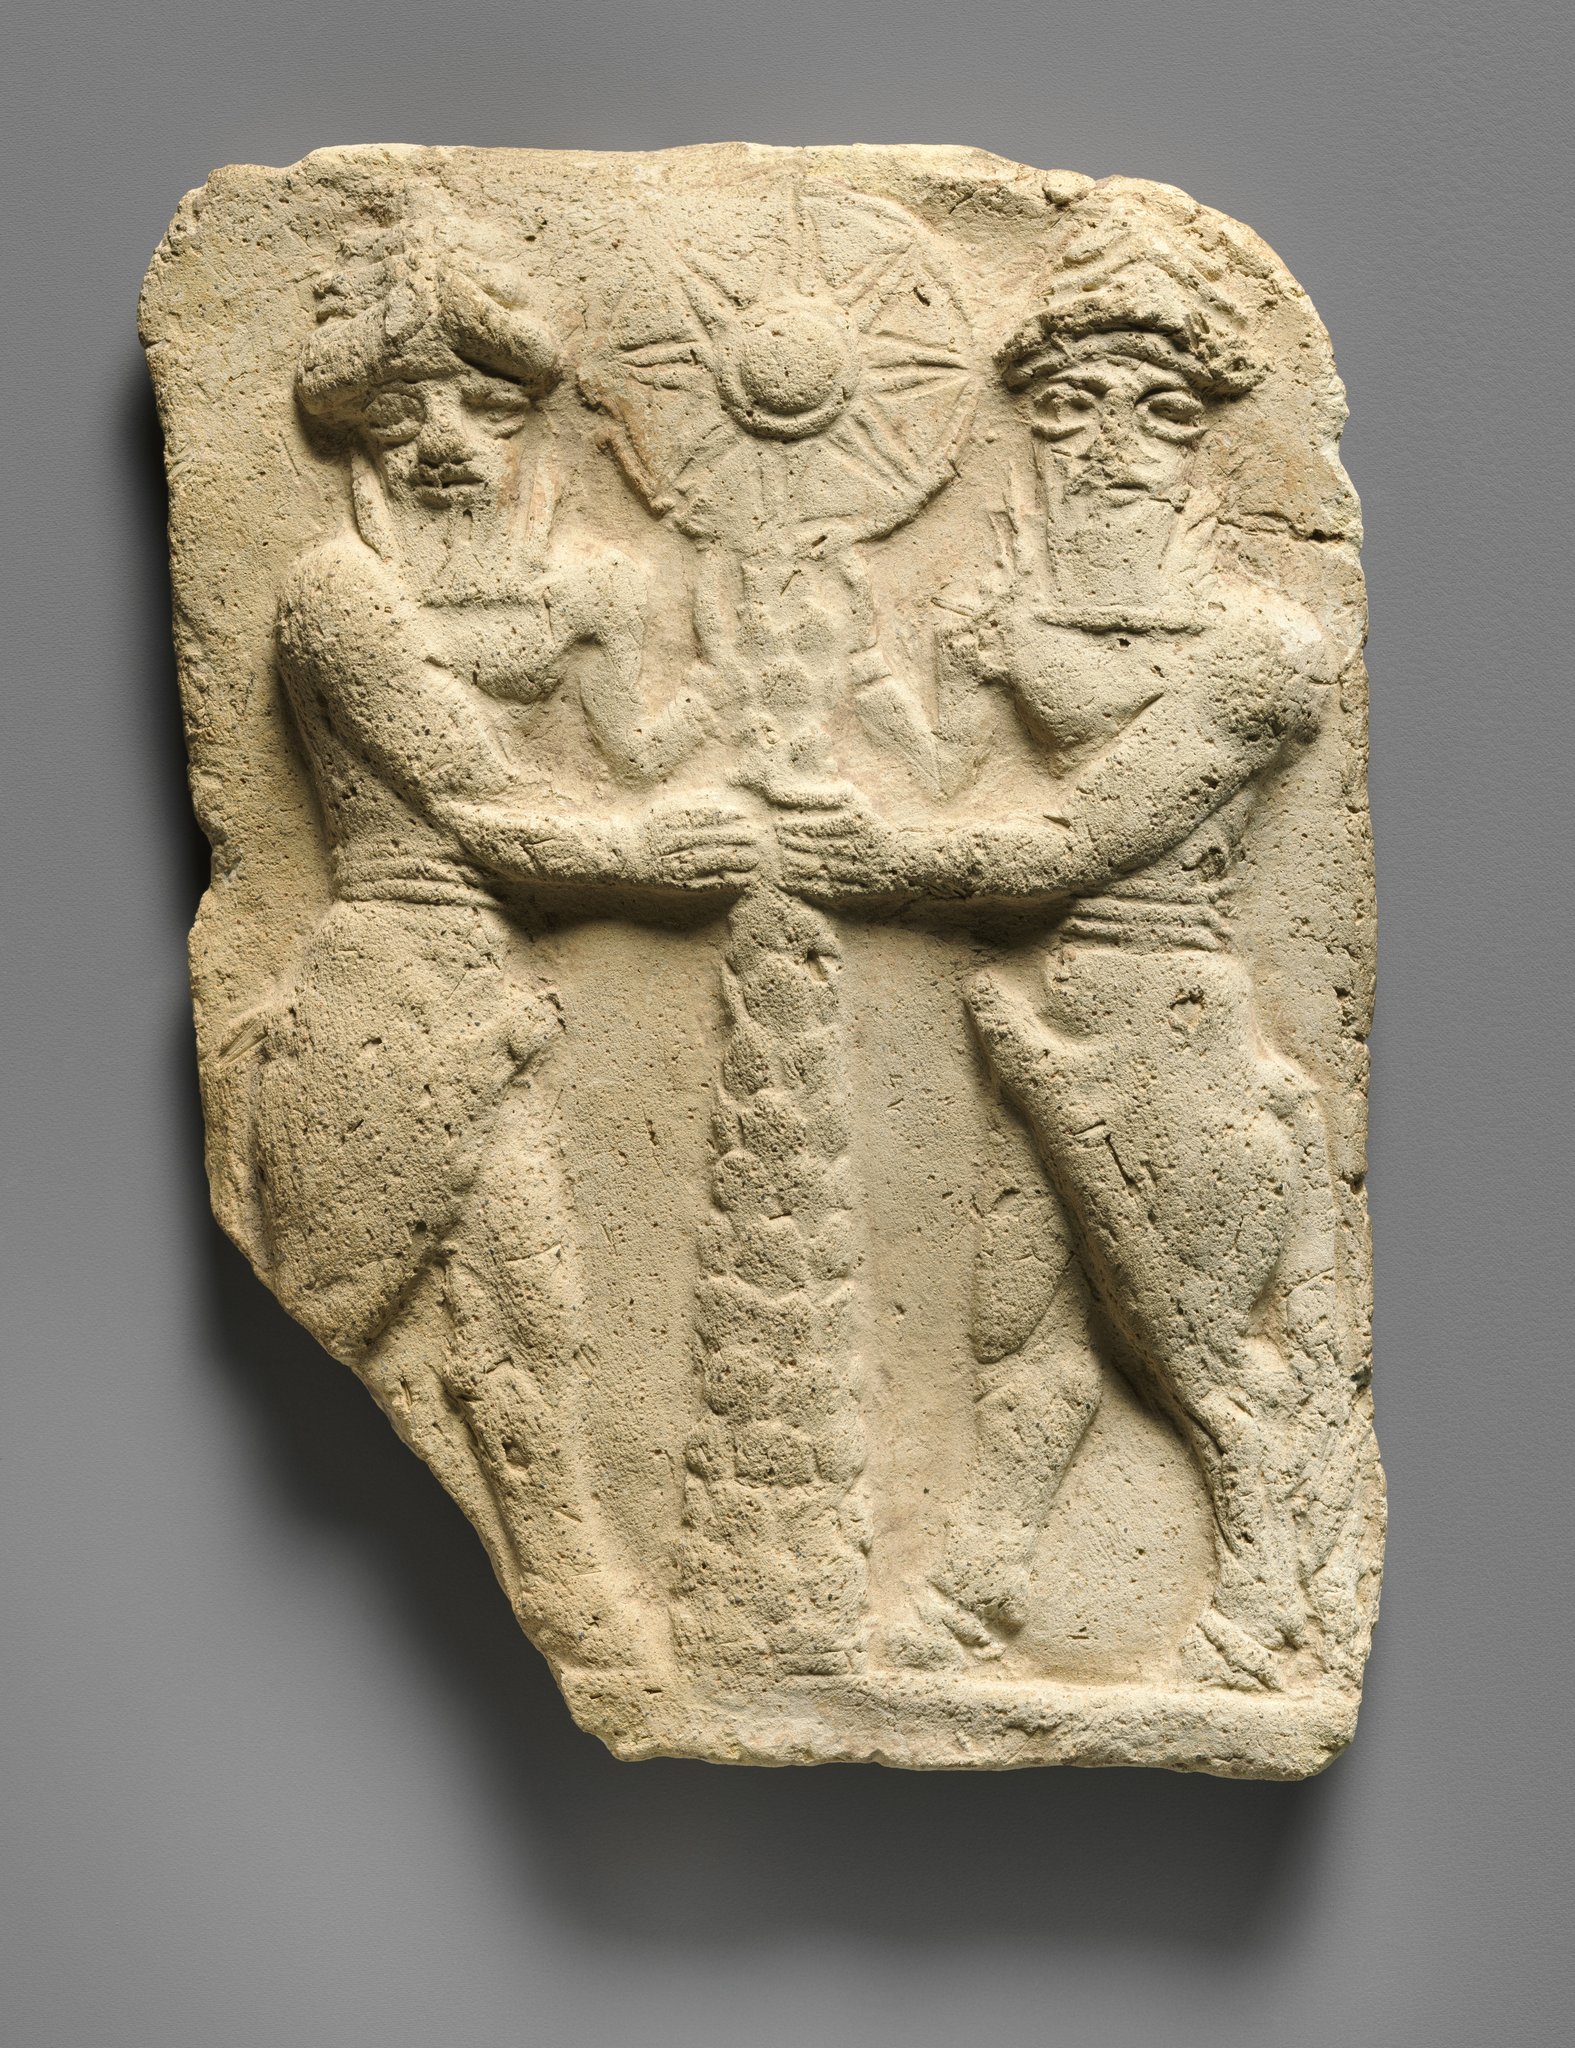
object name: relief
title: Molded plaque: bull-men flanking a tree trunk surmounted by a sun disc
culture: babylonian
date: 2000-1600 BCE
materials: ceramic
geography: southern mesopotamia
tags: men,trees